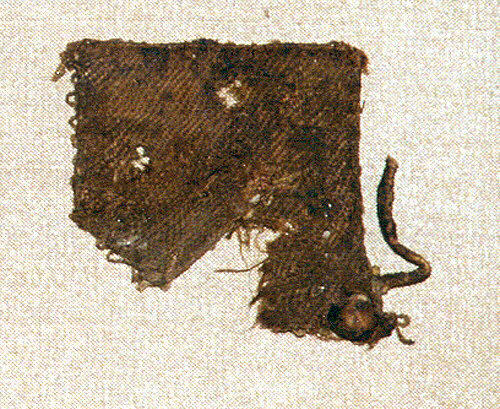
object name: textile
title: Silk patch from a tunic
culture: alanic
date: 601-900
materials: silk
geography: caucasus